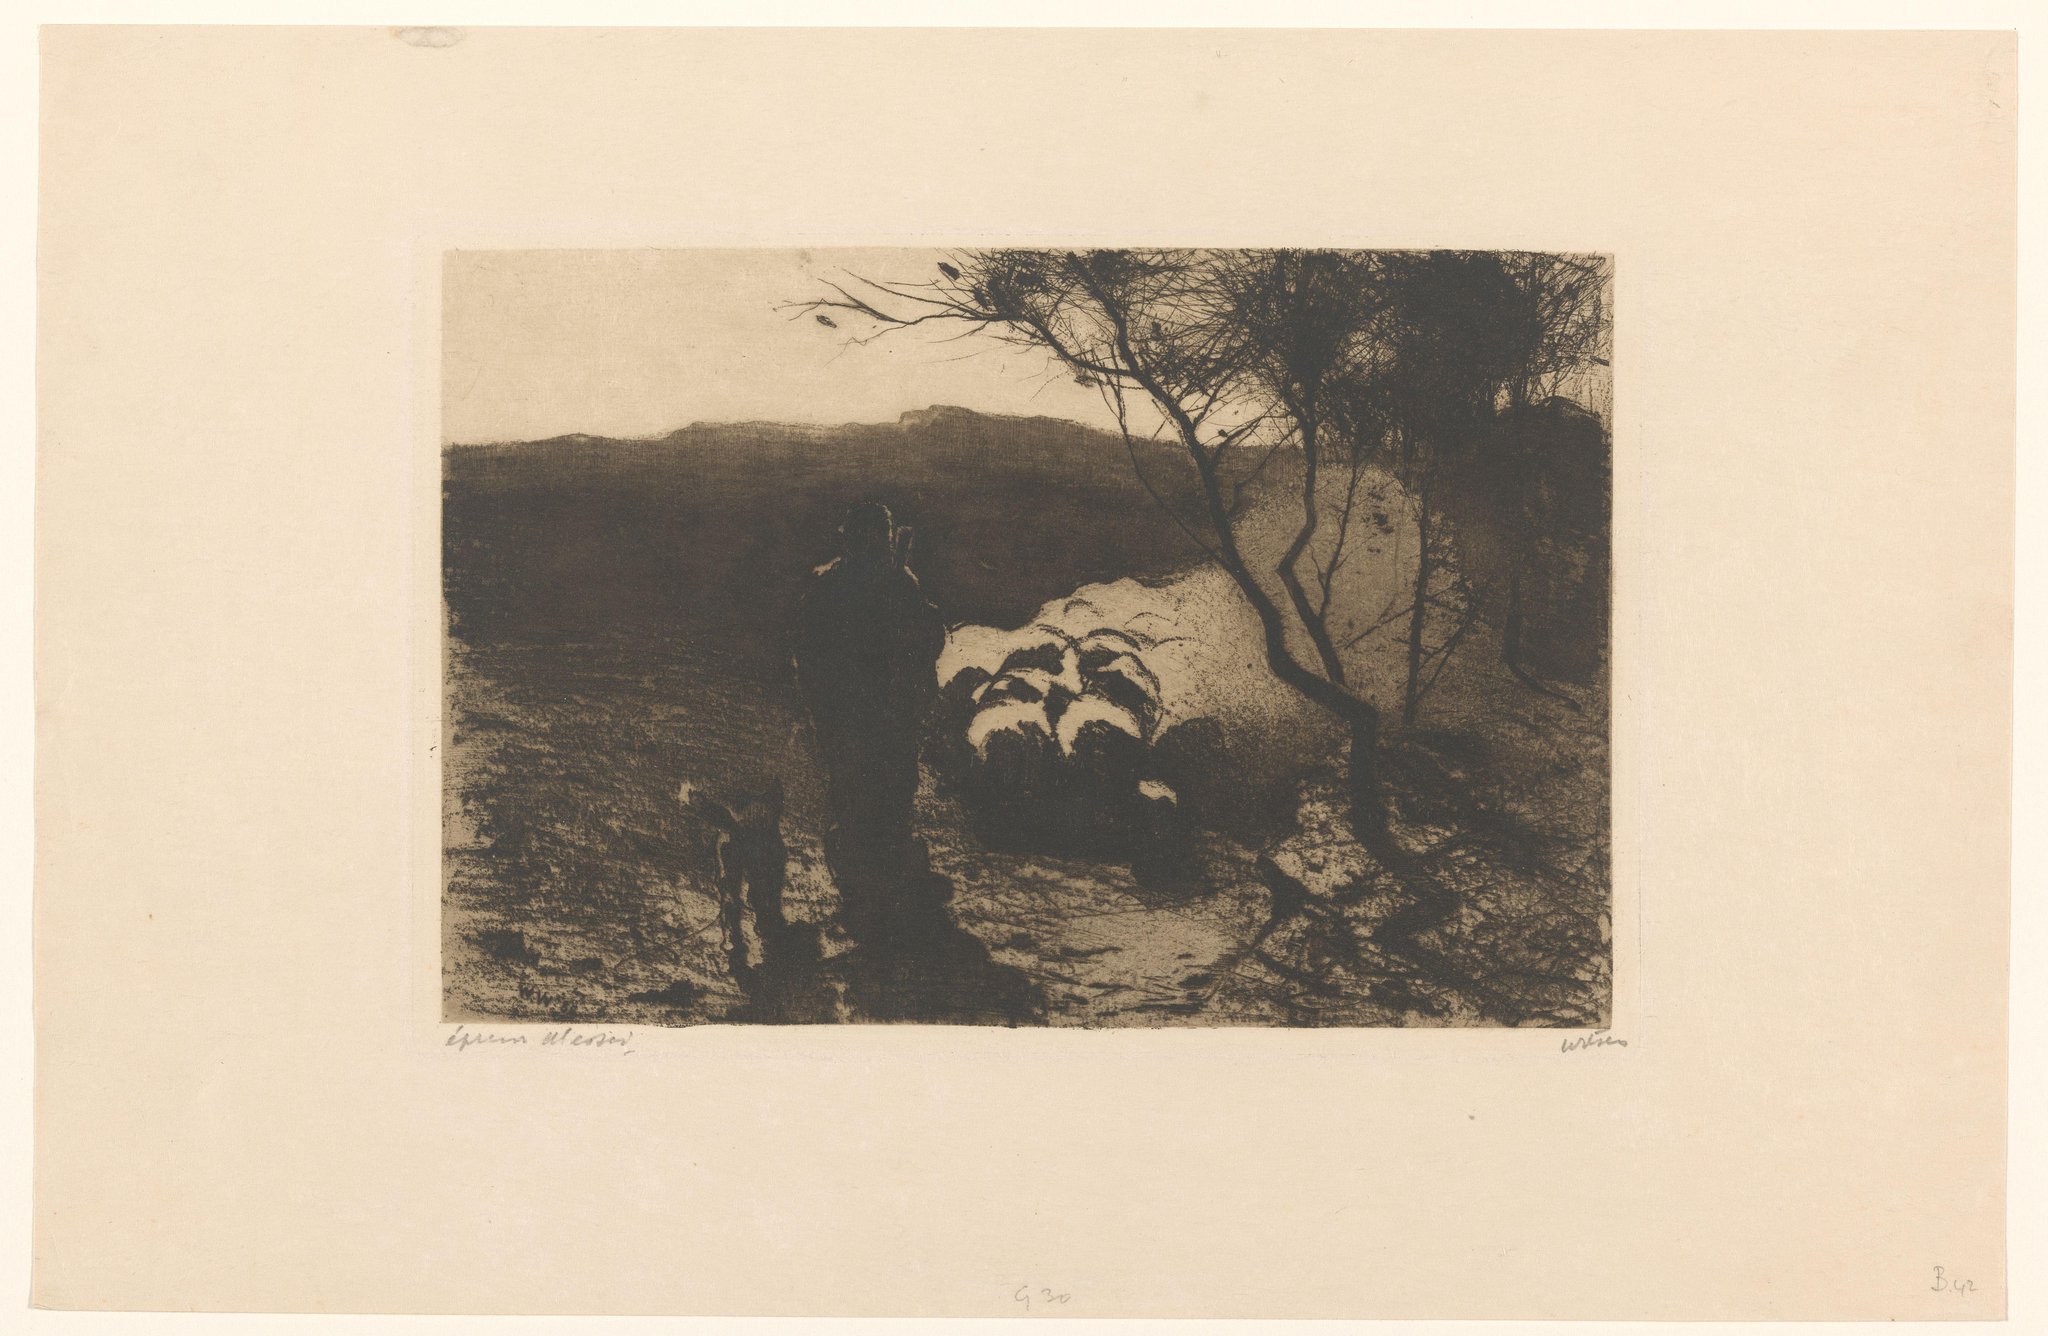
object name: print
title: Schaapherder met een hond achter zijn kudde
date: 1909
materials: paper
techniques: etching, intaglio, soft ground etching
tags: herding, herdsman, herdswoman, shepherd, shepherdess, cowherd, etc., sheep, dog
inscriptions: collector's mark: Lugt 2228, inscription: ‘épreuve d'essai’, signature: ‘Witsen’